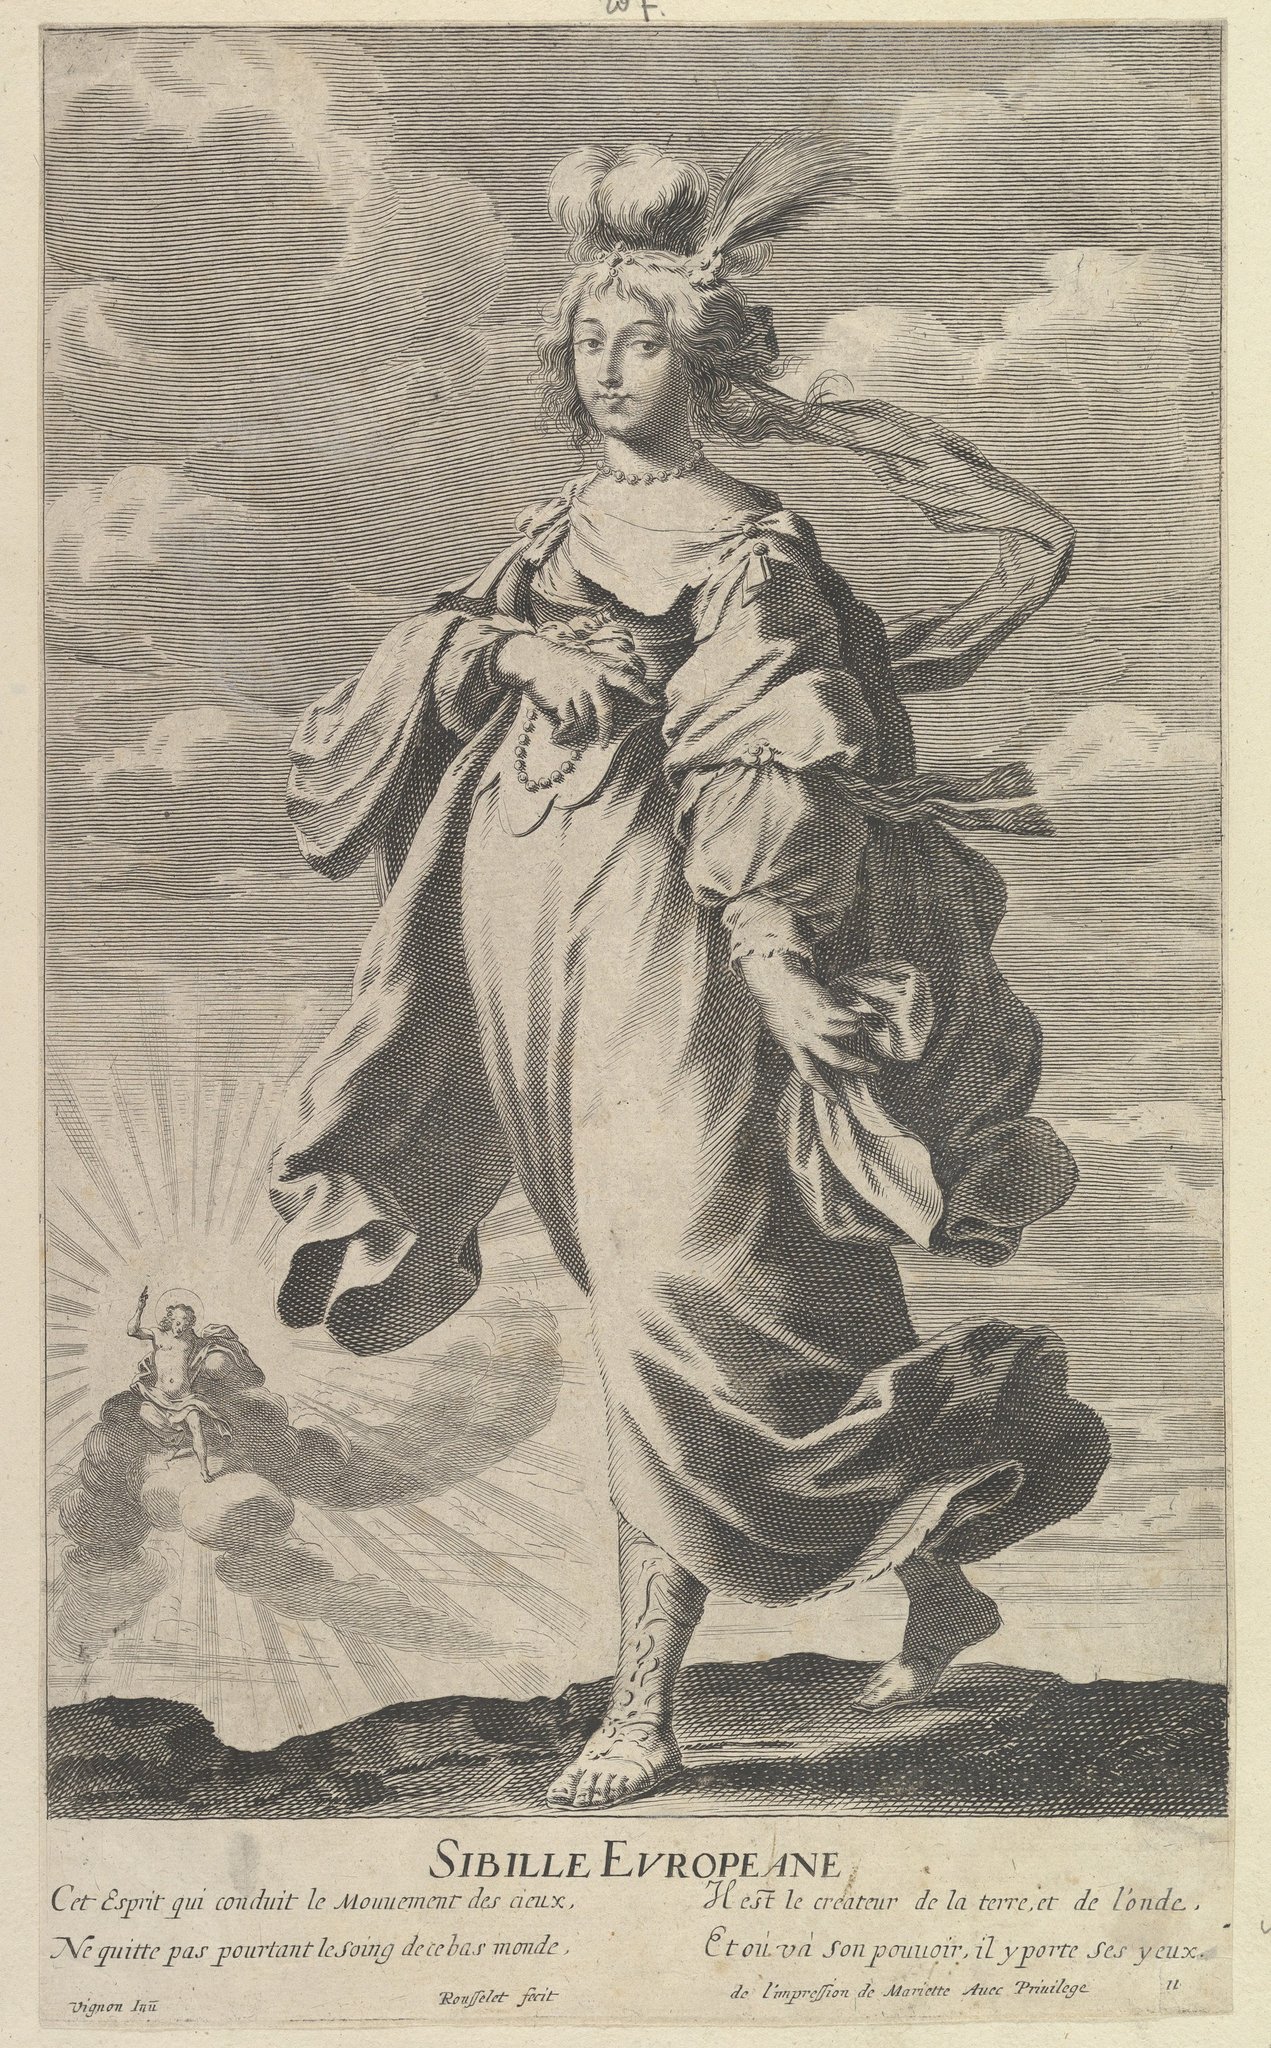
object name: print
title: Sibyl of Europe, from La Galerie des femmes fortes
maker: gilles rousselet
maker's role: artist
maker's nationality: french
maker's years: 1614-1686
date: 1635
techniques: engraving, etching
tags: women